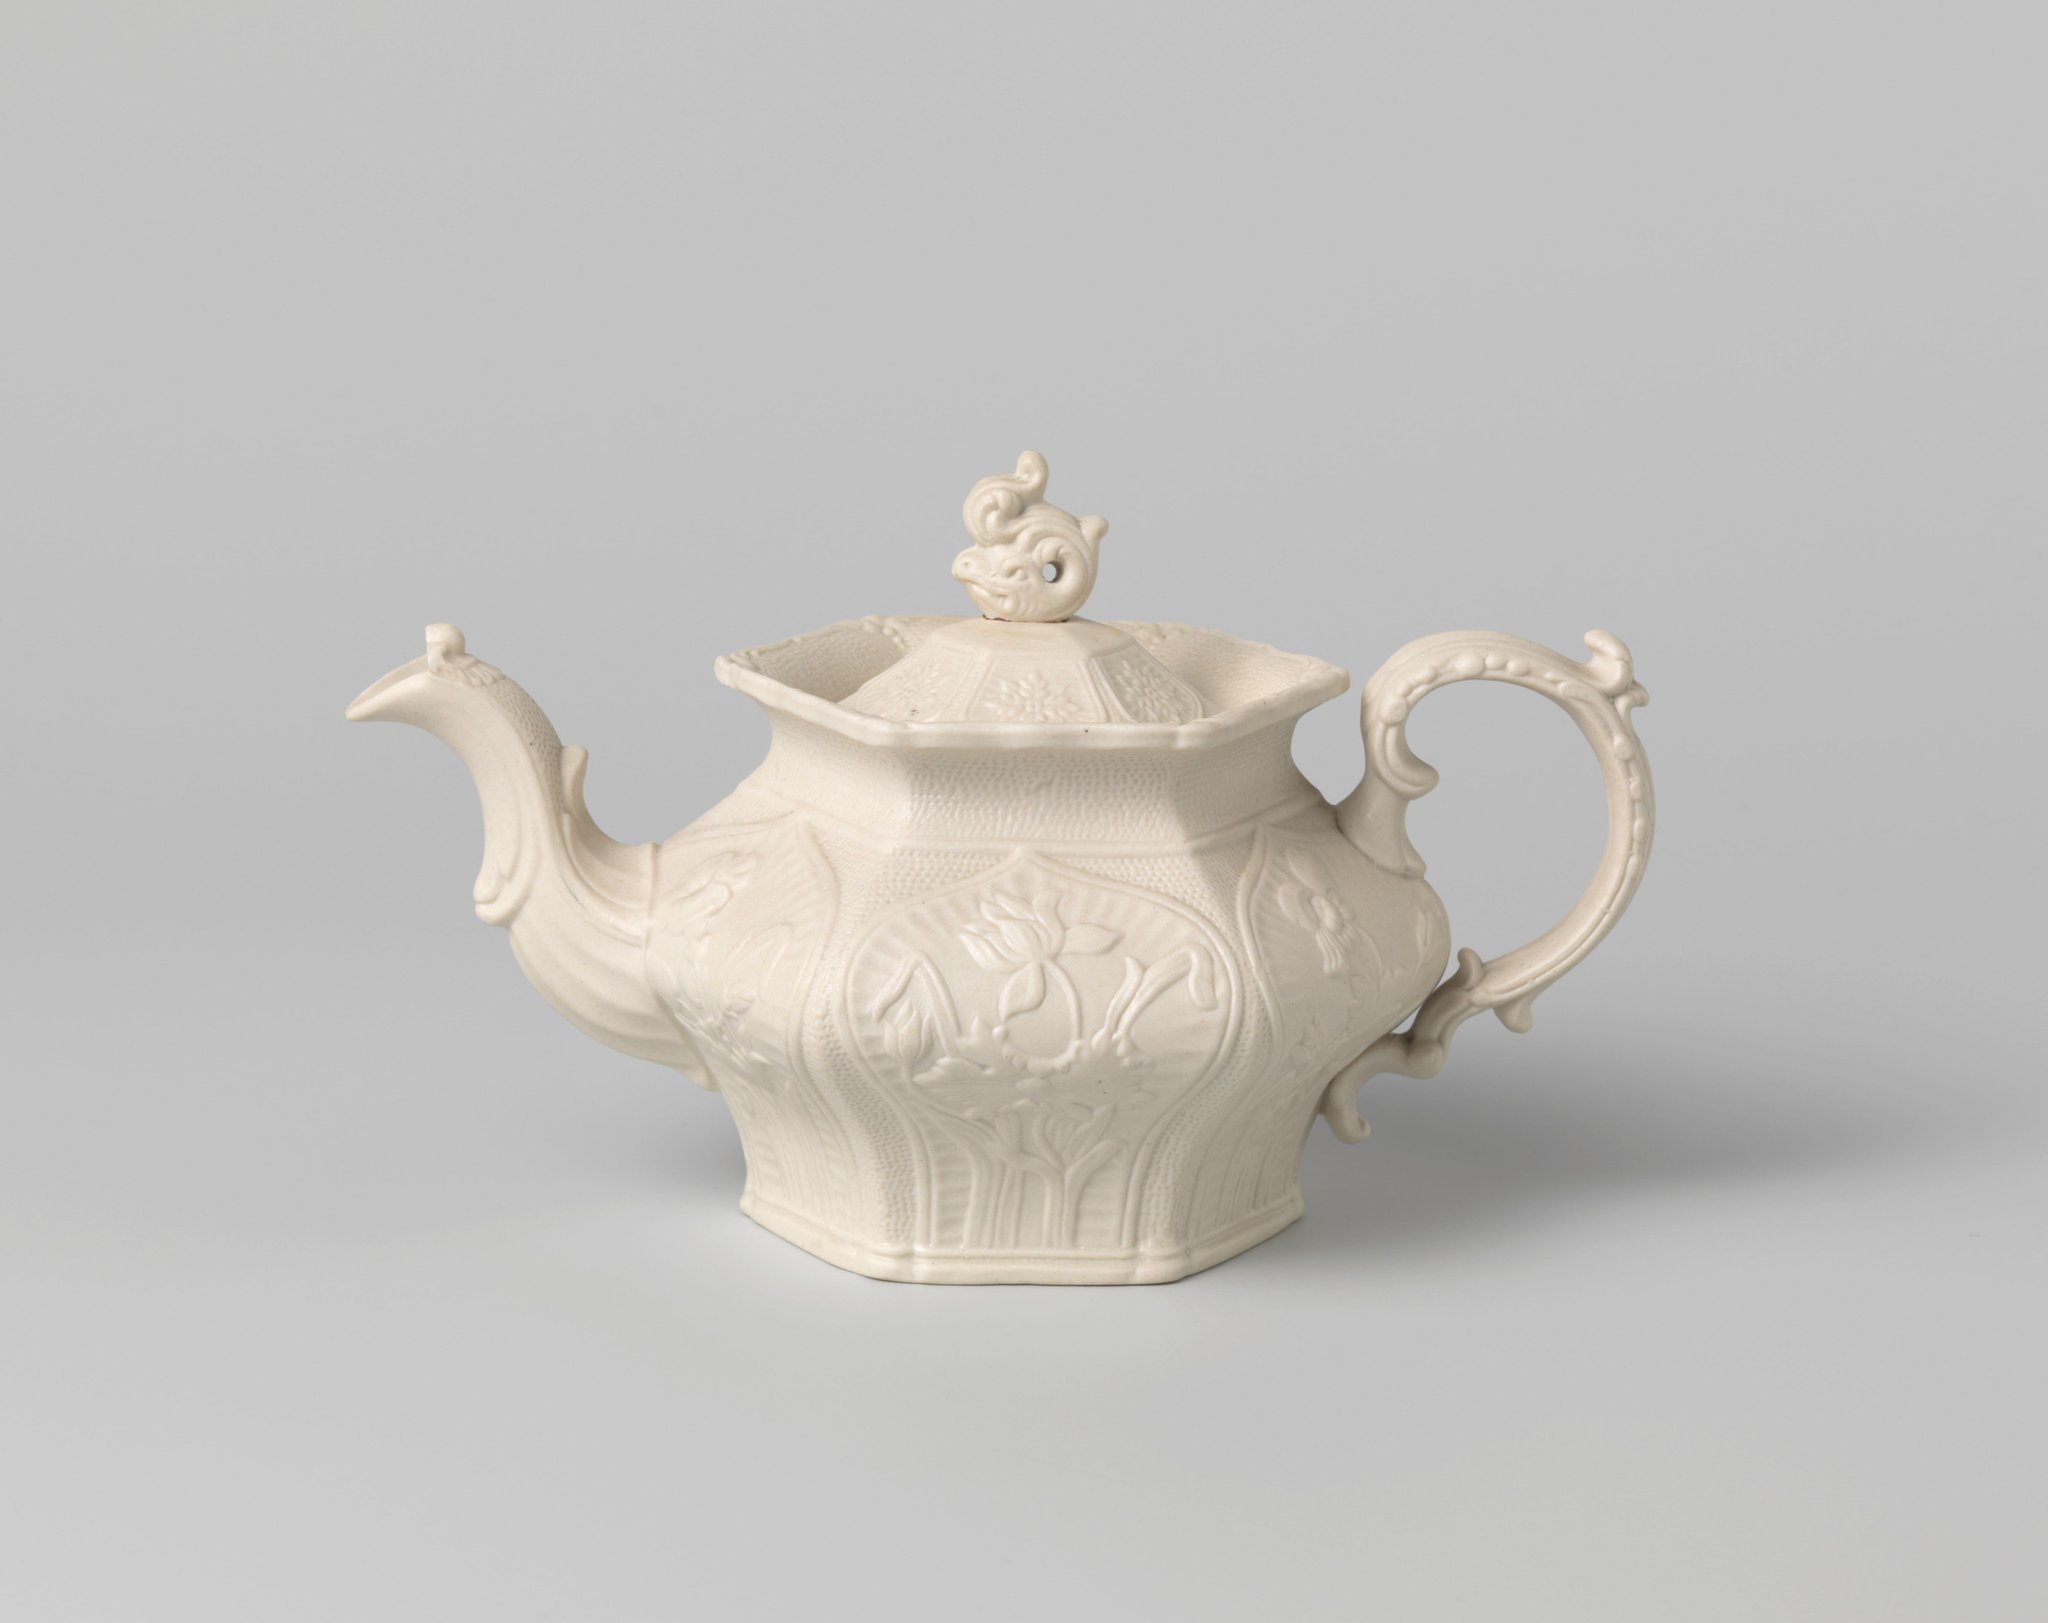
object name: lid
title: Deksel, zeshoekig, gres blanc, met cartouches met bloemen in reliëf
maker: petrus regout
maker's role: plateelbakker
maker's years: 1801-1879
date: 1870-1890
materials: stoneware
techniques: vitrification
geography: maastricht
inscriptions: mark: ‘P. REGOUT // MAASTRICHT // 13’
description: Het zeshoekige deksel is in reliëf gedecoreerd met zes ui-vormige cartouches tegen een gematteerde achtergrond, waarin bloemen in reliëf. De knop heeft de vorm van een vis. In het deksel een luchtgat.